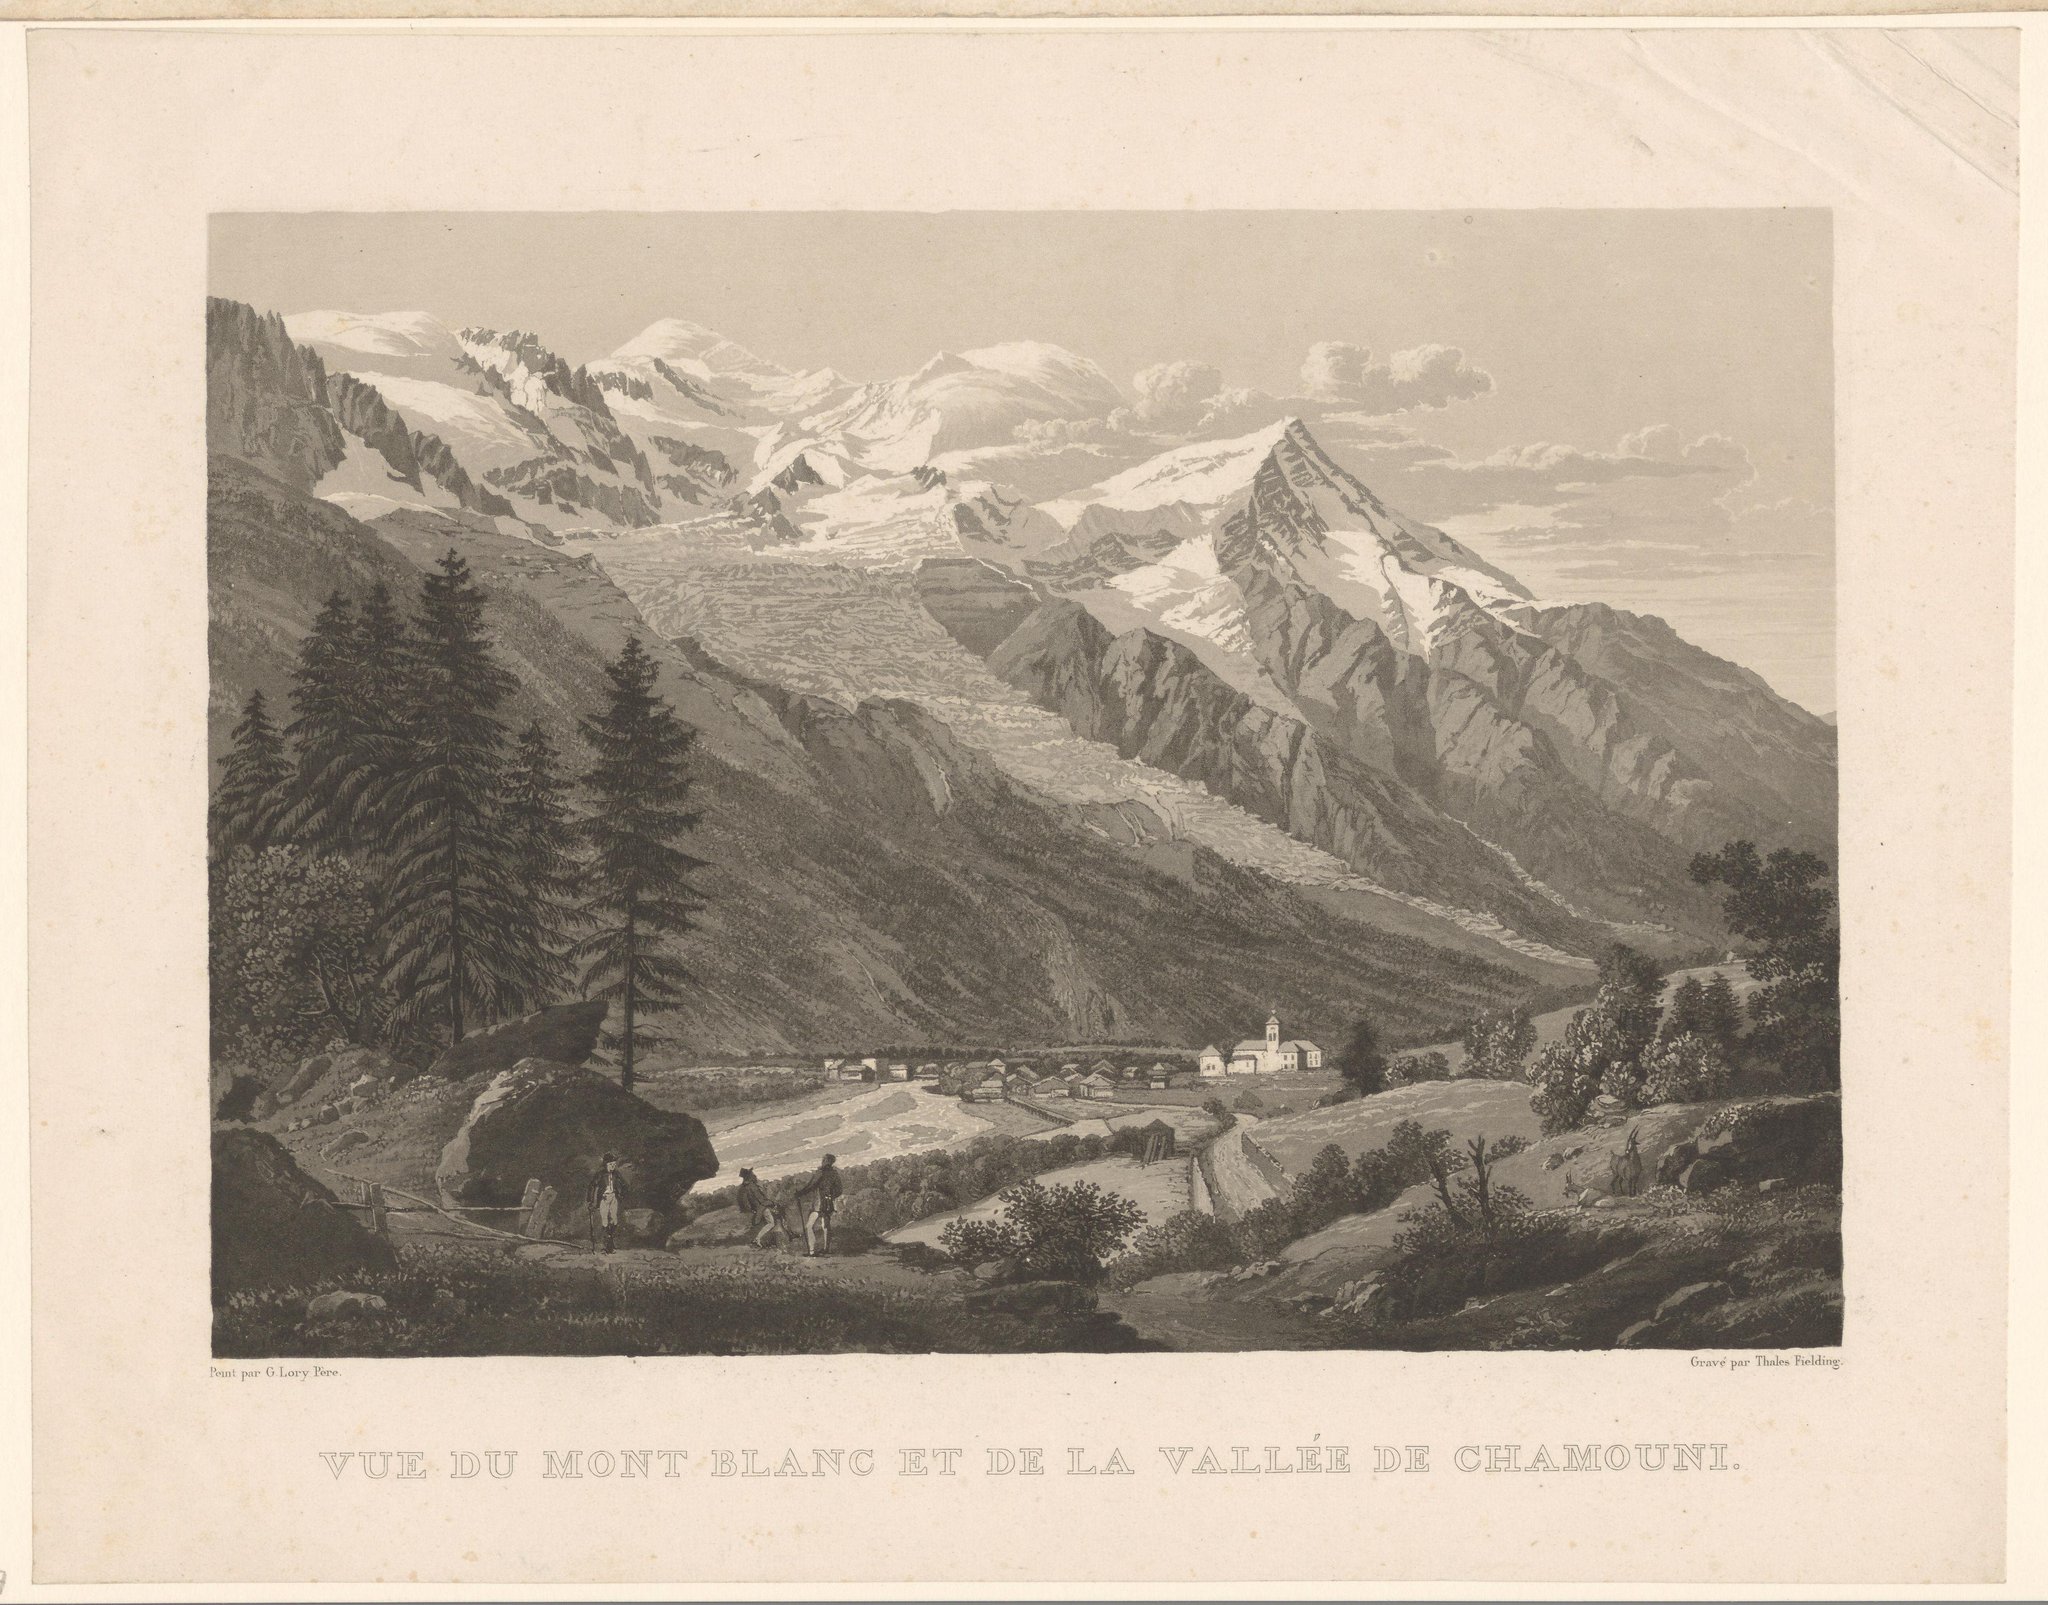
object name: print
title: Vue du Mont Blanc et de la Vallée de Chamount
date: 1823-1827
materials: paper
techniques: aquatint, etching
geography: paris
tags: dale, valley, mountains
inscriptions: collector's mark: Lugt 2228